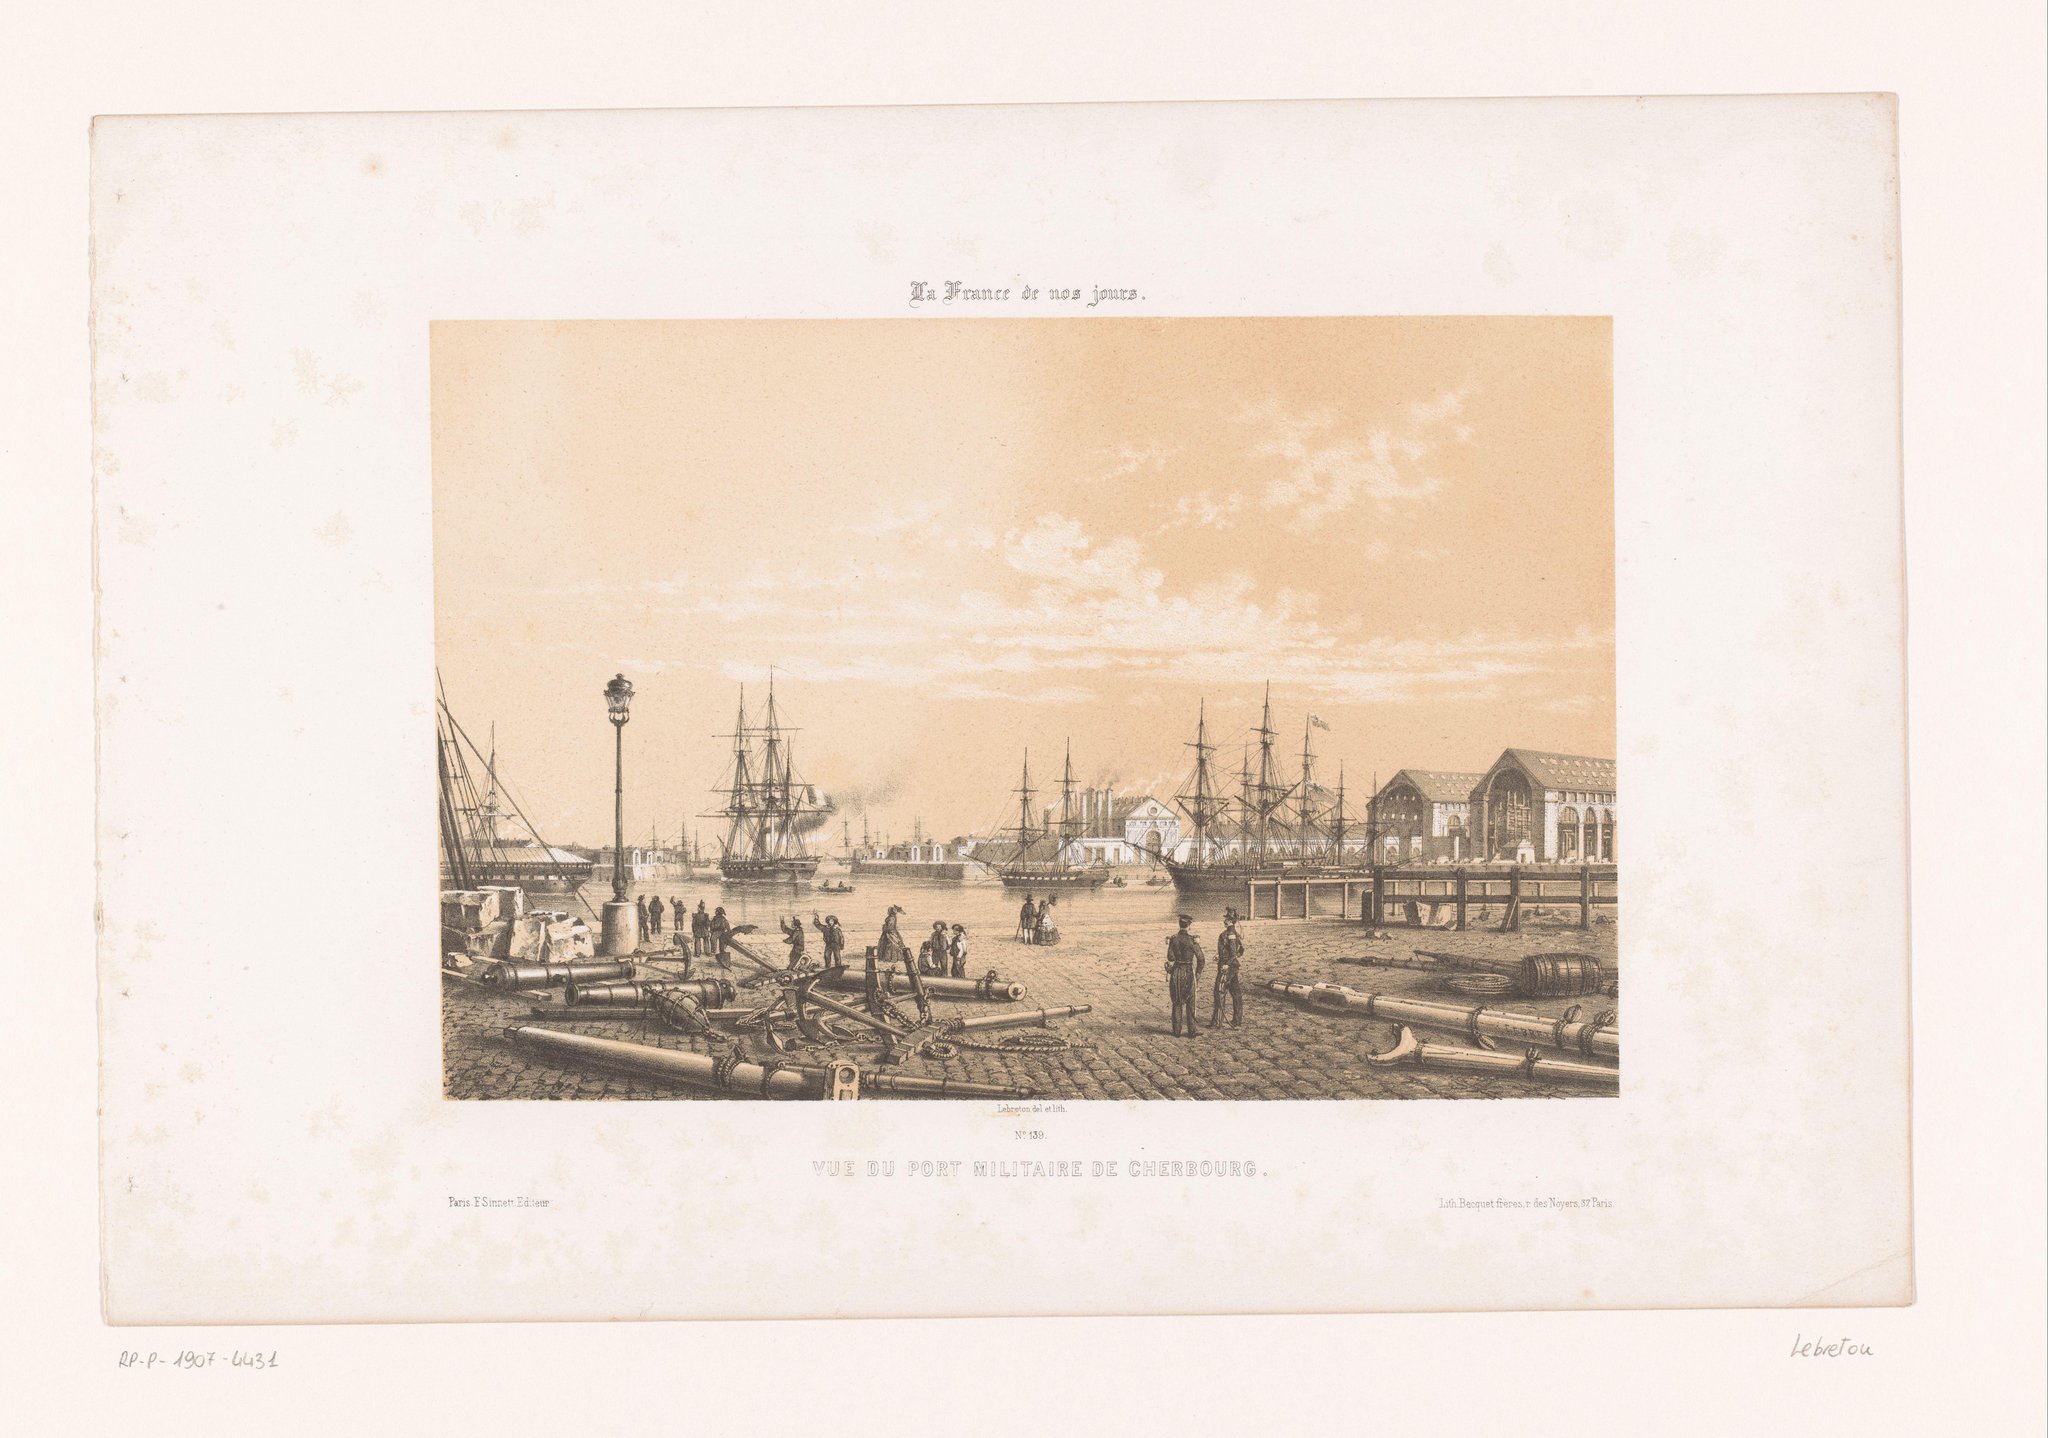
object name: print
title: Zicht op de militaire standplaats van de marine bij de haven van Cherbourg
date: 1855-1859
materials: paper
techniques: tone lithography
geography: paris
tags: harbour, barracks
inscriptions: collector's mark: Lugt 2228a